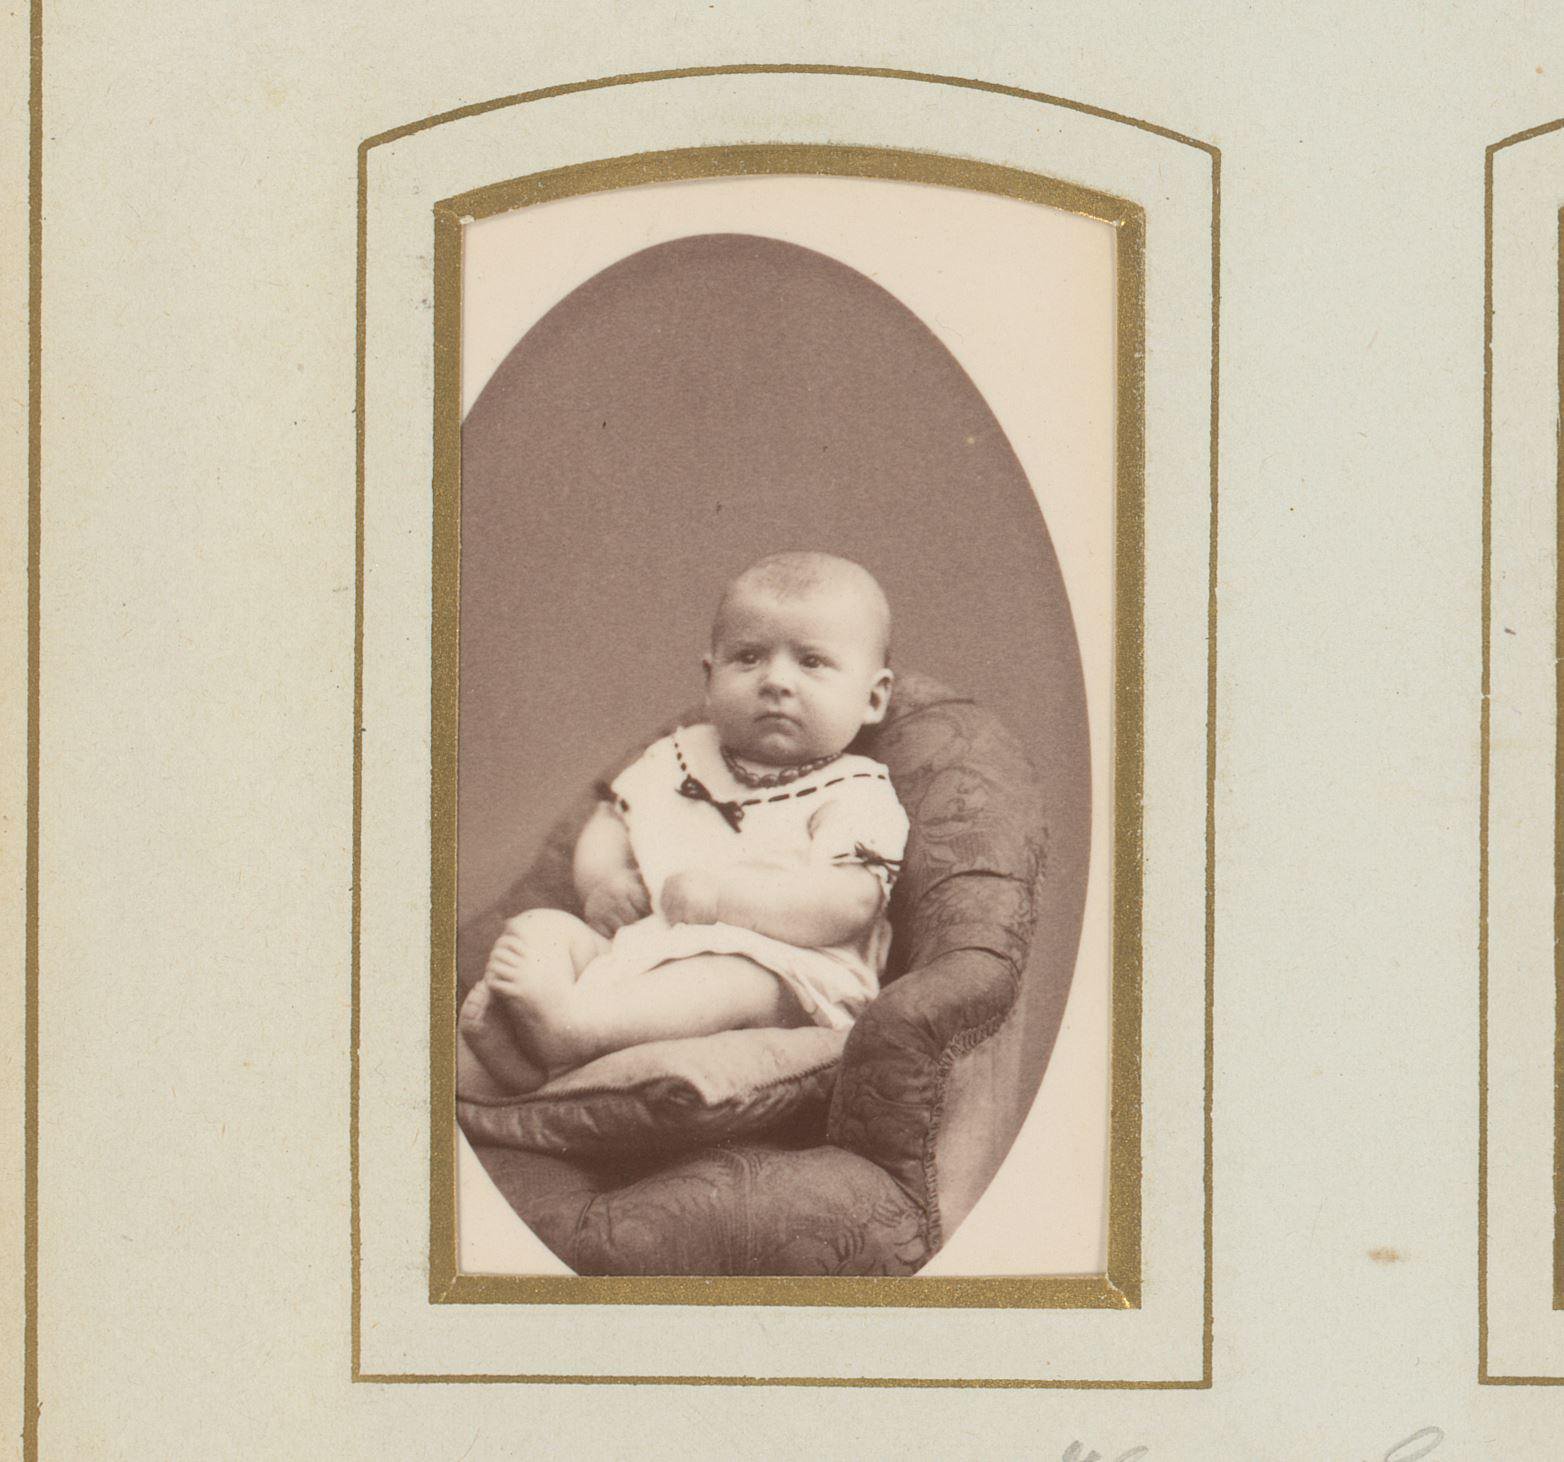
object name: photograph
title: Portret van Henri Ernie als baby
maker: marius rouffiac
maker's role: fotograaf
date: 1880-1900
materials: cardboard, celluloid, photographic support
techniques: albumen print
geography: paris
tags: historical persons, infant, baby ~ the ages of man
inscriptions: name: ‘Henri Ernie +1915’, inscription: ‘PHOTOGRAPHIE/ MARIUS/ 55 Rue Réaumur 55/ Paris/ Les clichés sont conservés.’